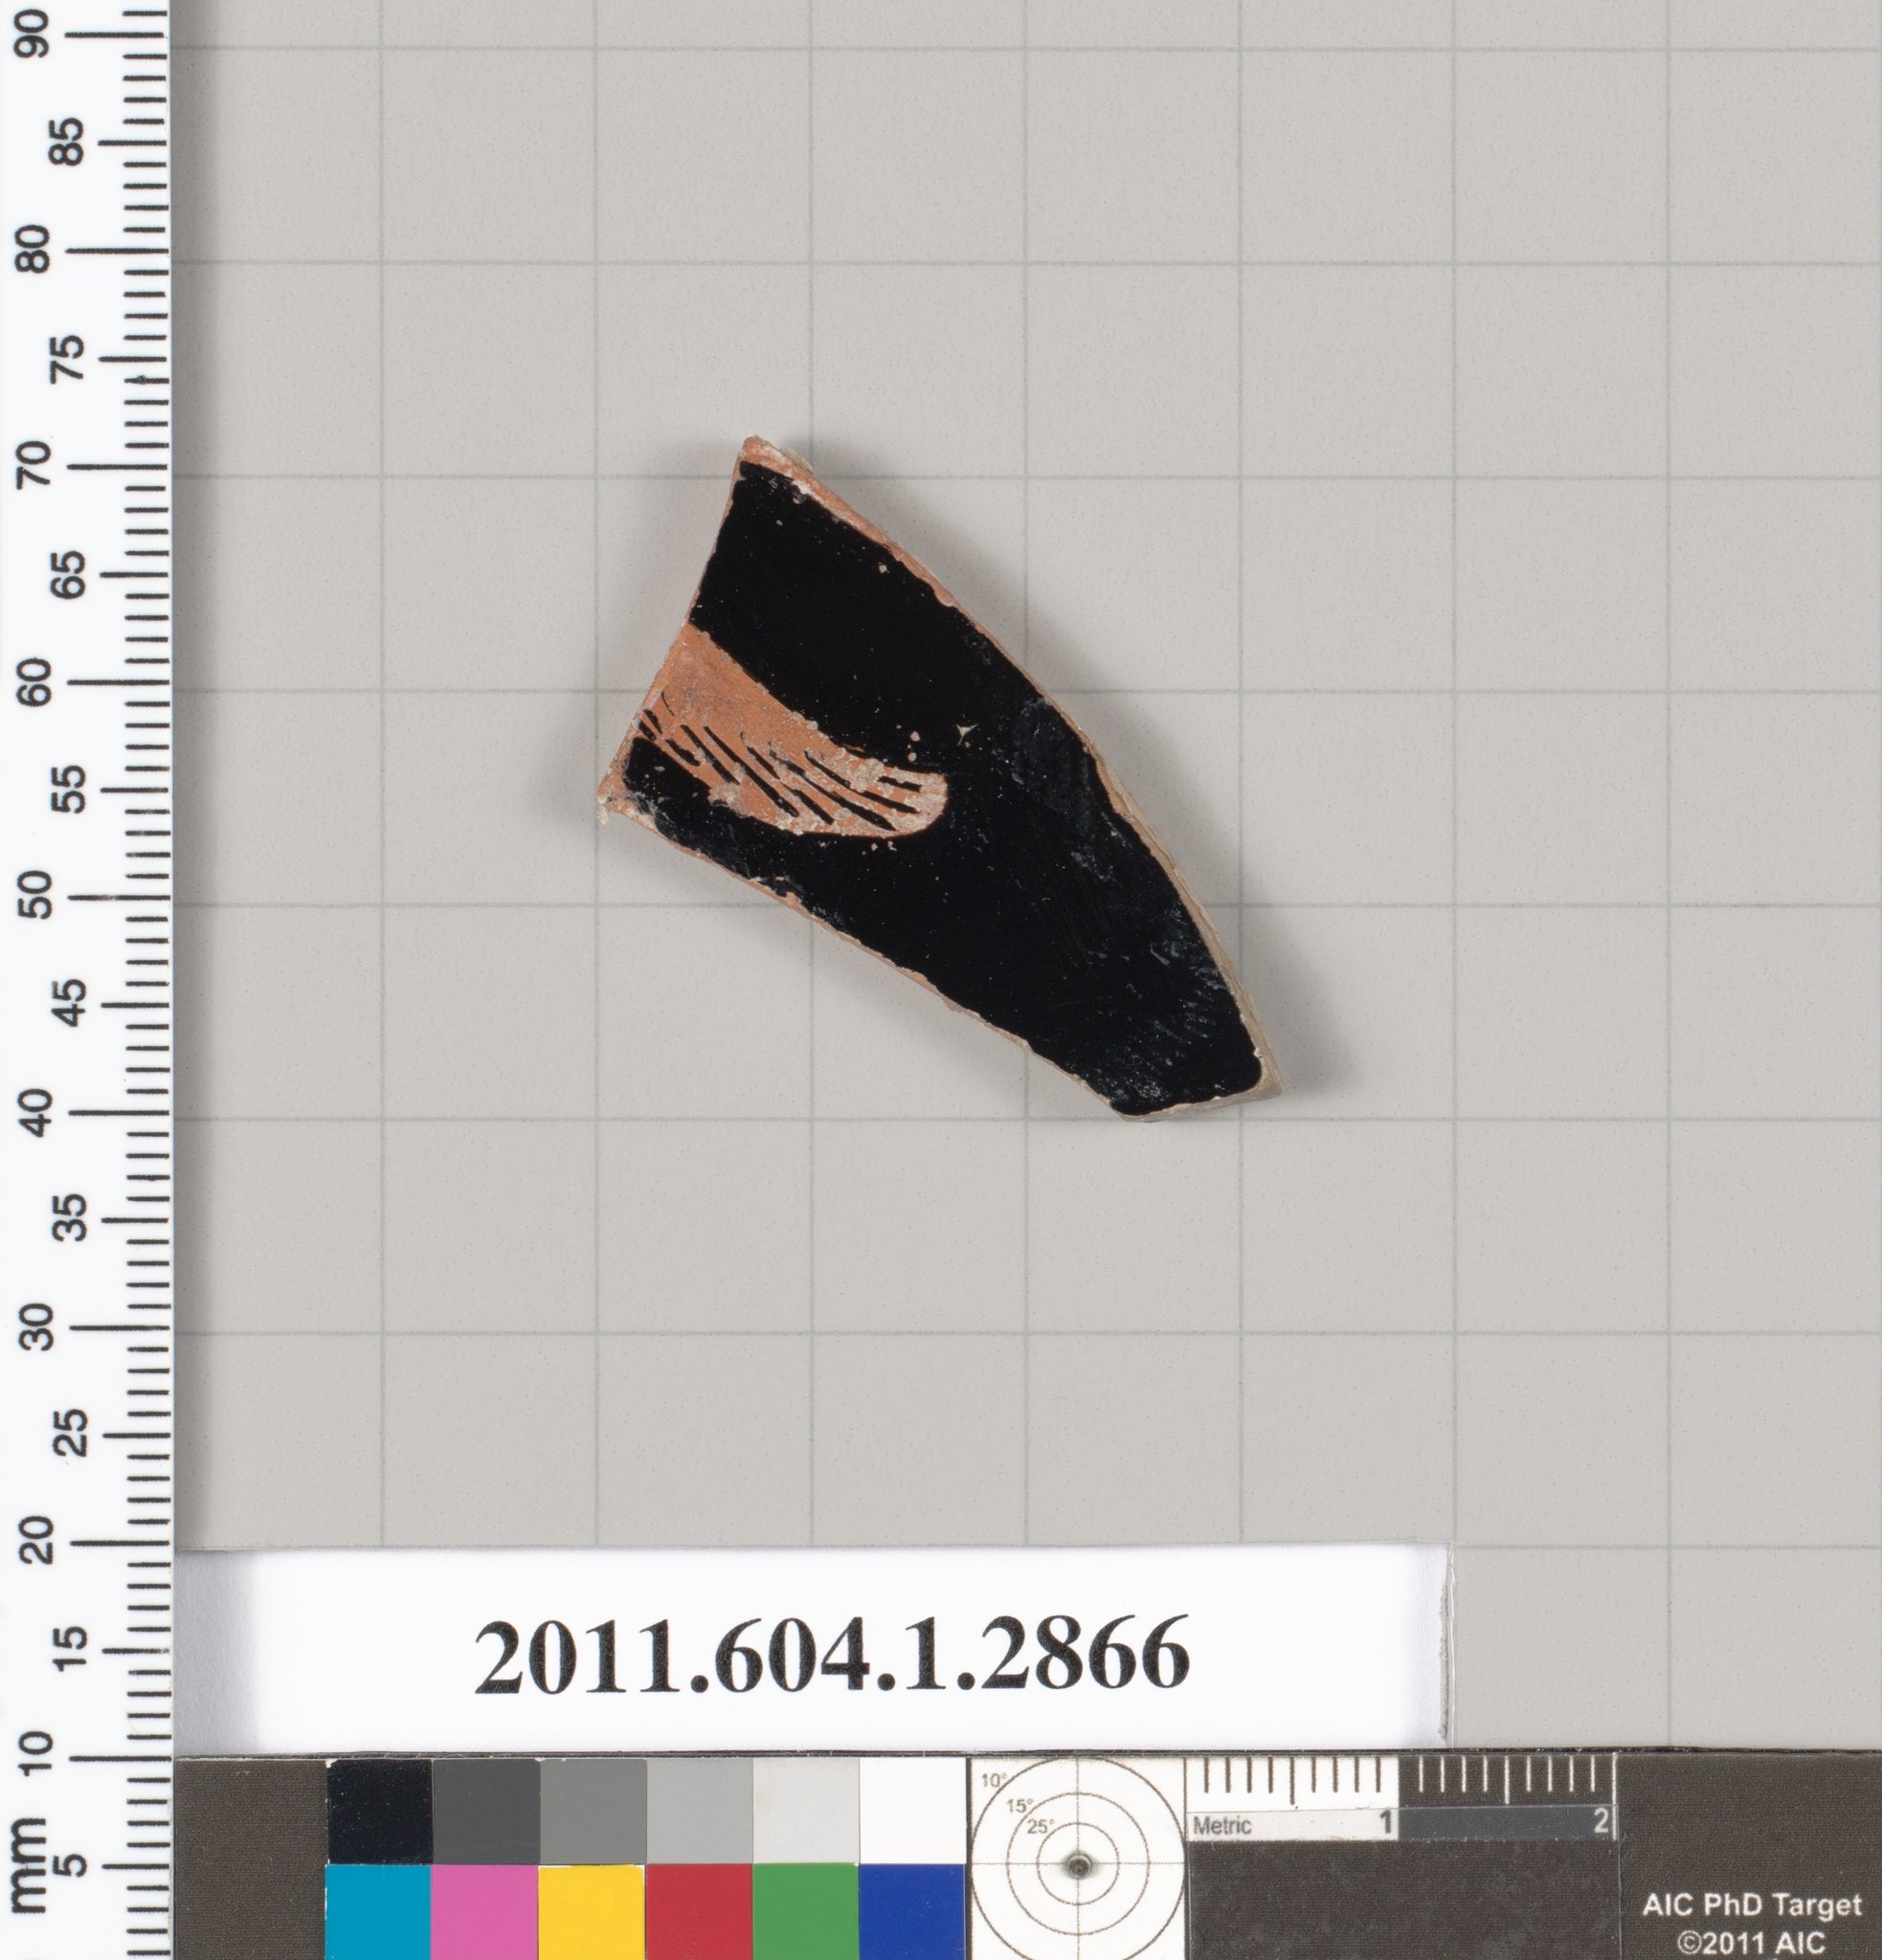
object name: kylix fragment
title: Terracotta fragment of a kylix (drinking cup)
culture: greek, attic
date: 480-470 BCE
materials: terracotta